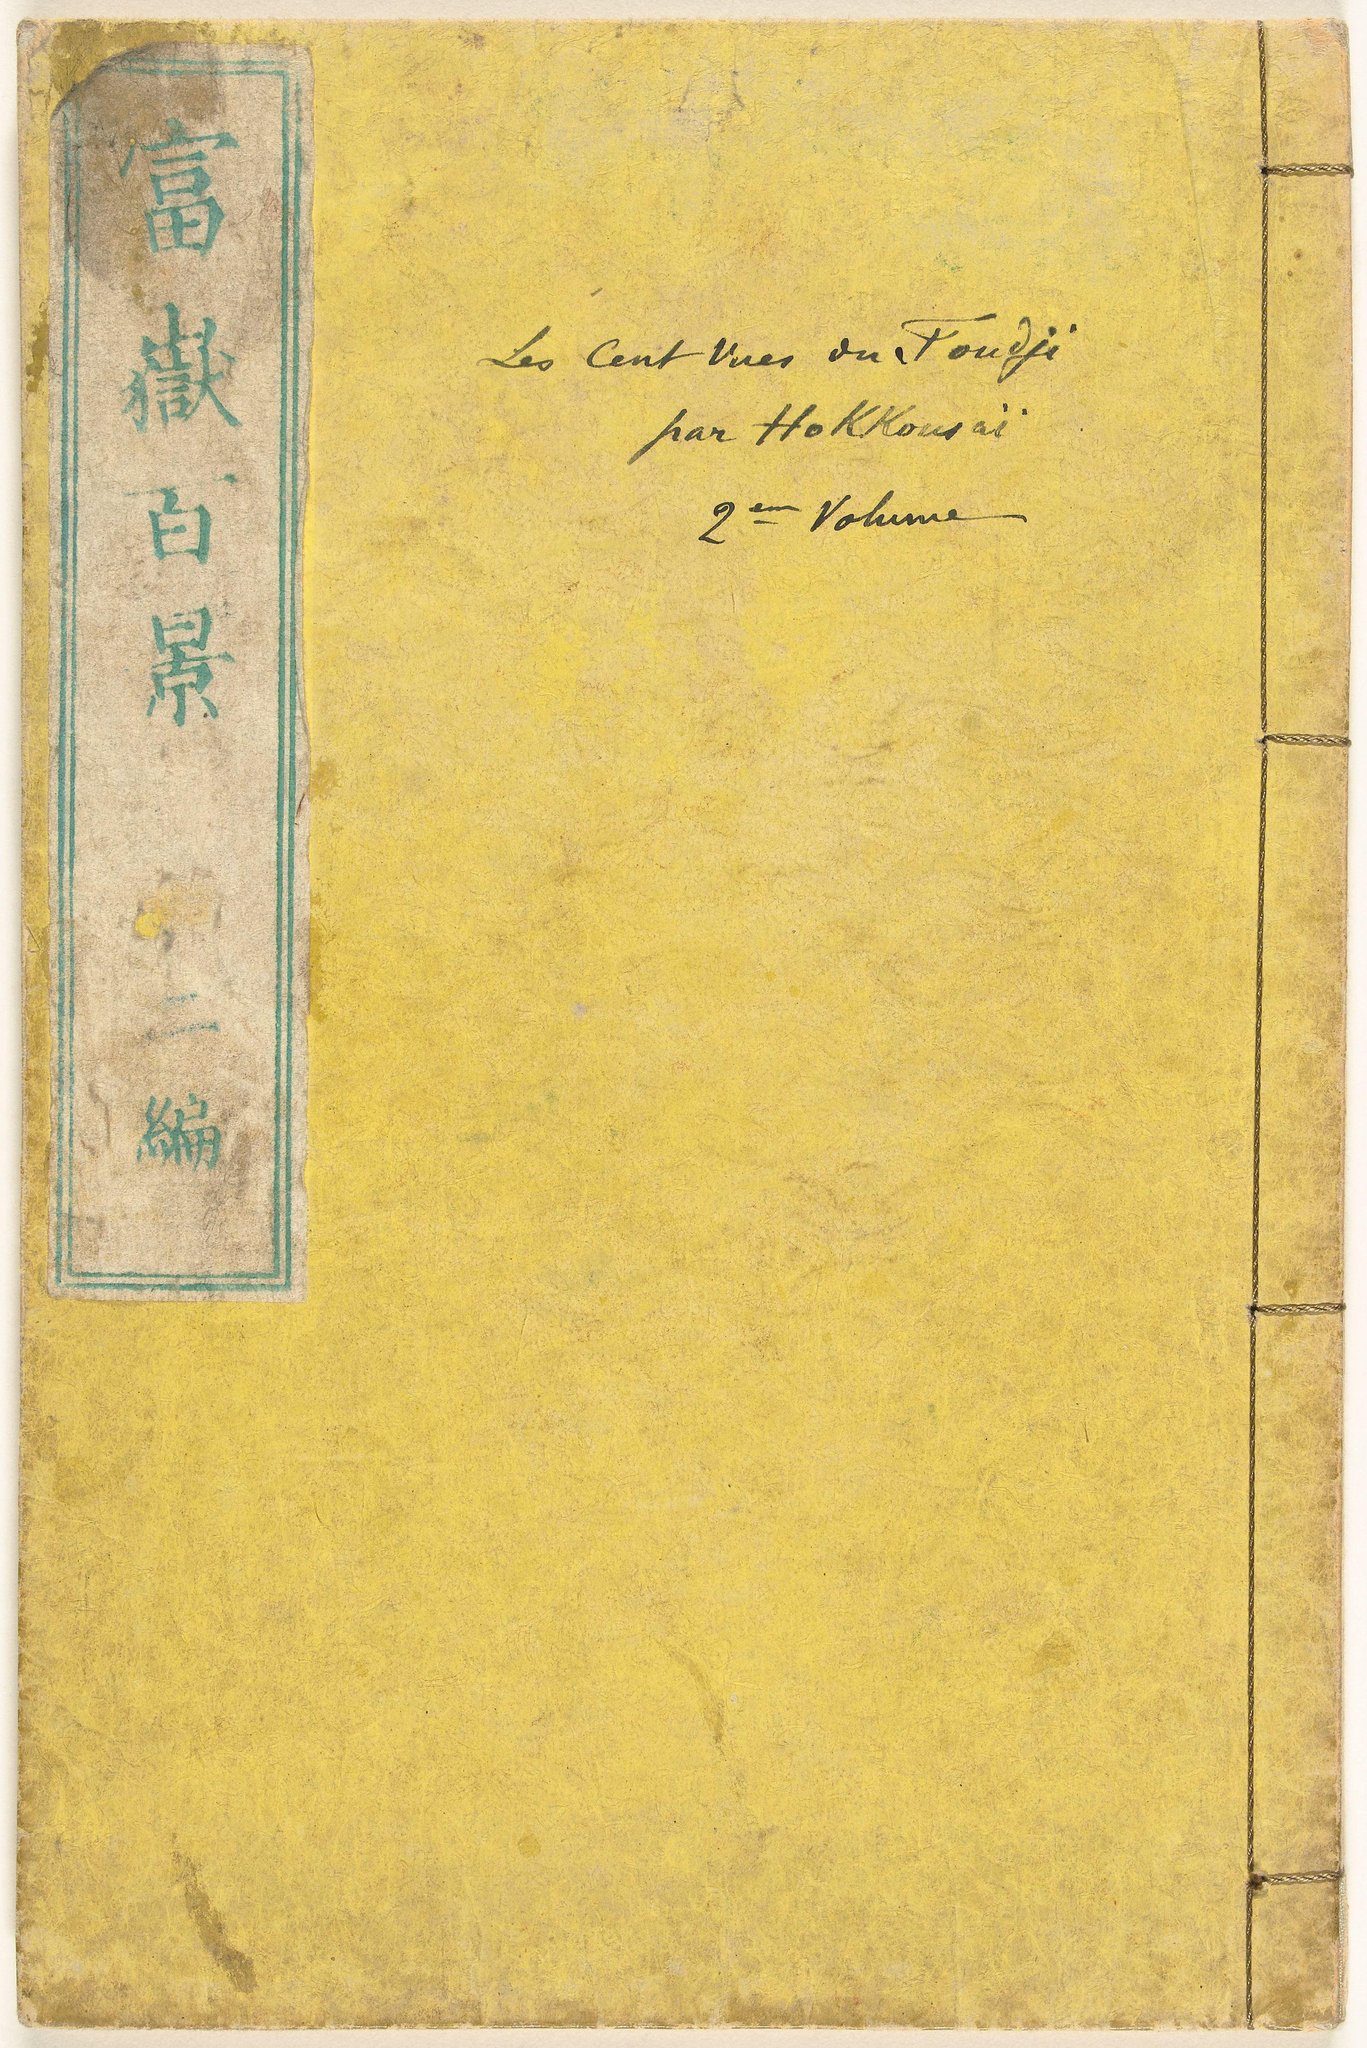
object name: book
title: Honderd gezichten op de berg Fuji - deel twee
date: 1876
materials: paper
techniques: woodcut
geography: nagoya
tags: fuji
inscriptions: date